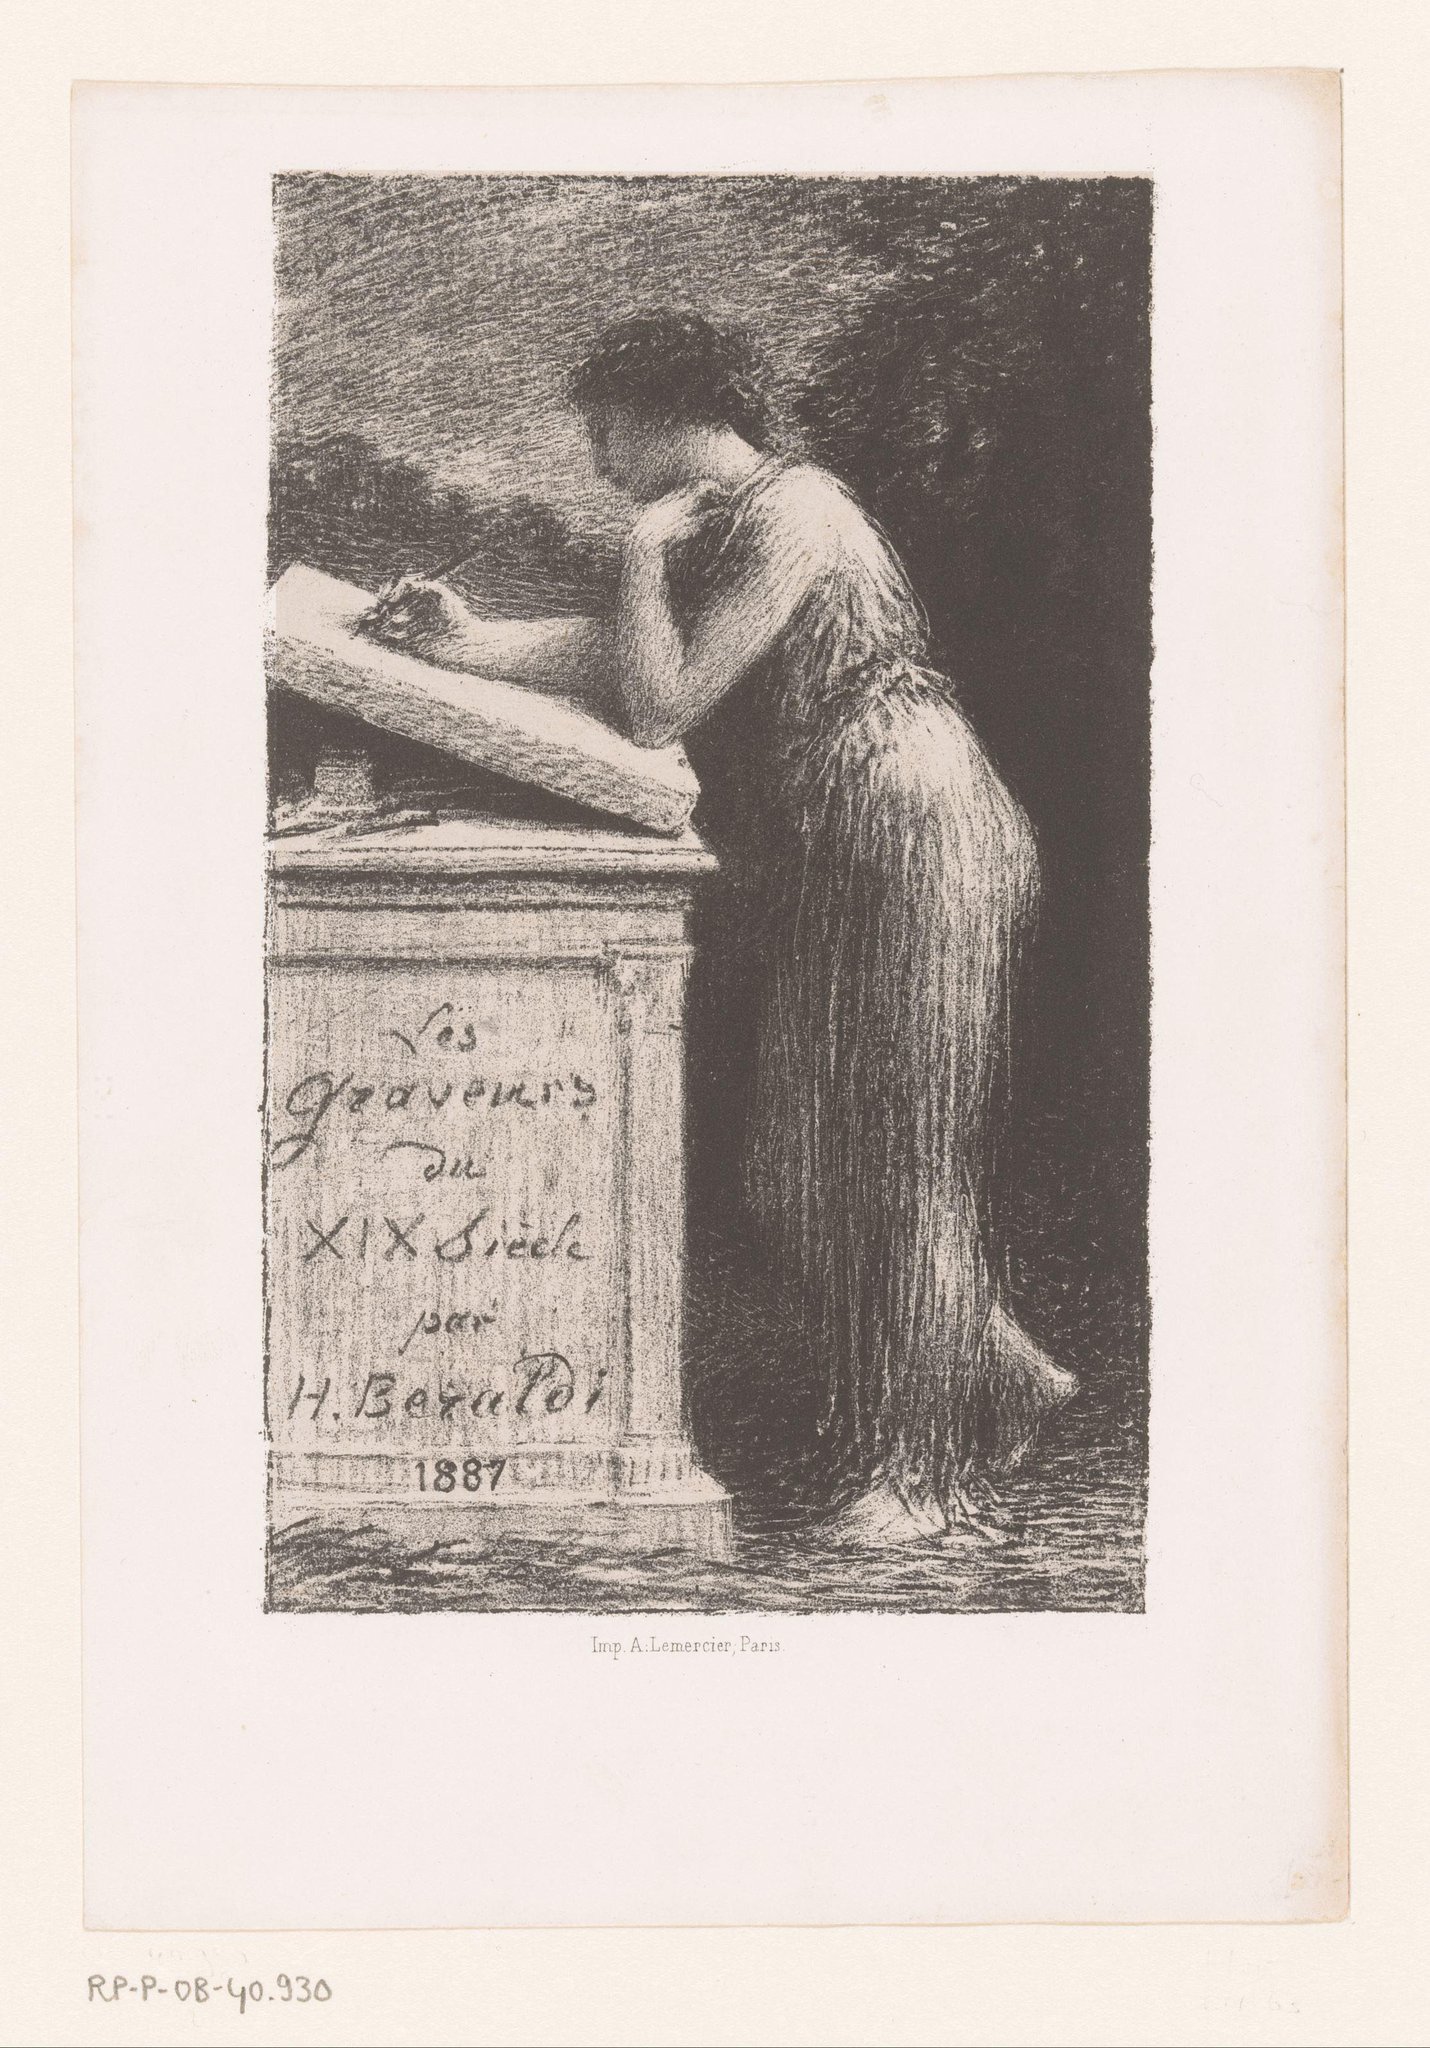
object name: titelprent, frontispice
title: Titelprent voor: Les Graveurs du XIX siècle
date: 1887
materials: paper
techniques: lithography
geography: paris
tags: symbolic representations, allegories and emblems ~ the graphic arts (+ artist at work)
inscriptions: date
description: Prent gebruikt voor: M.H. Beraldi, Les Graveurs du XIXe Siècle, Parijs 1887.